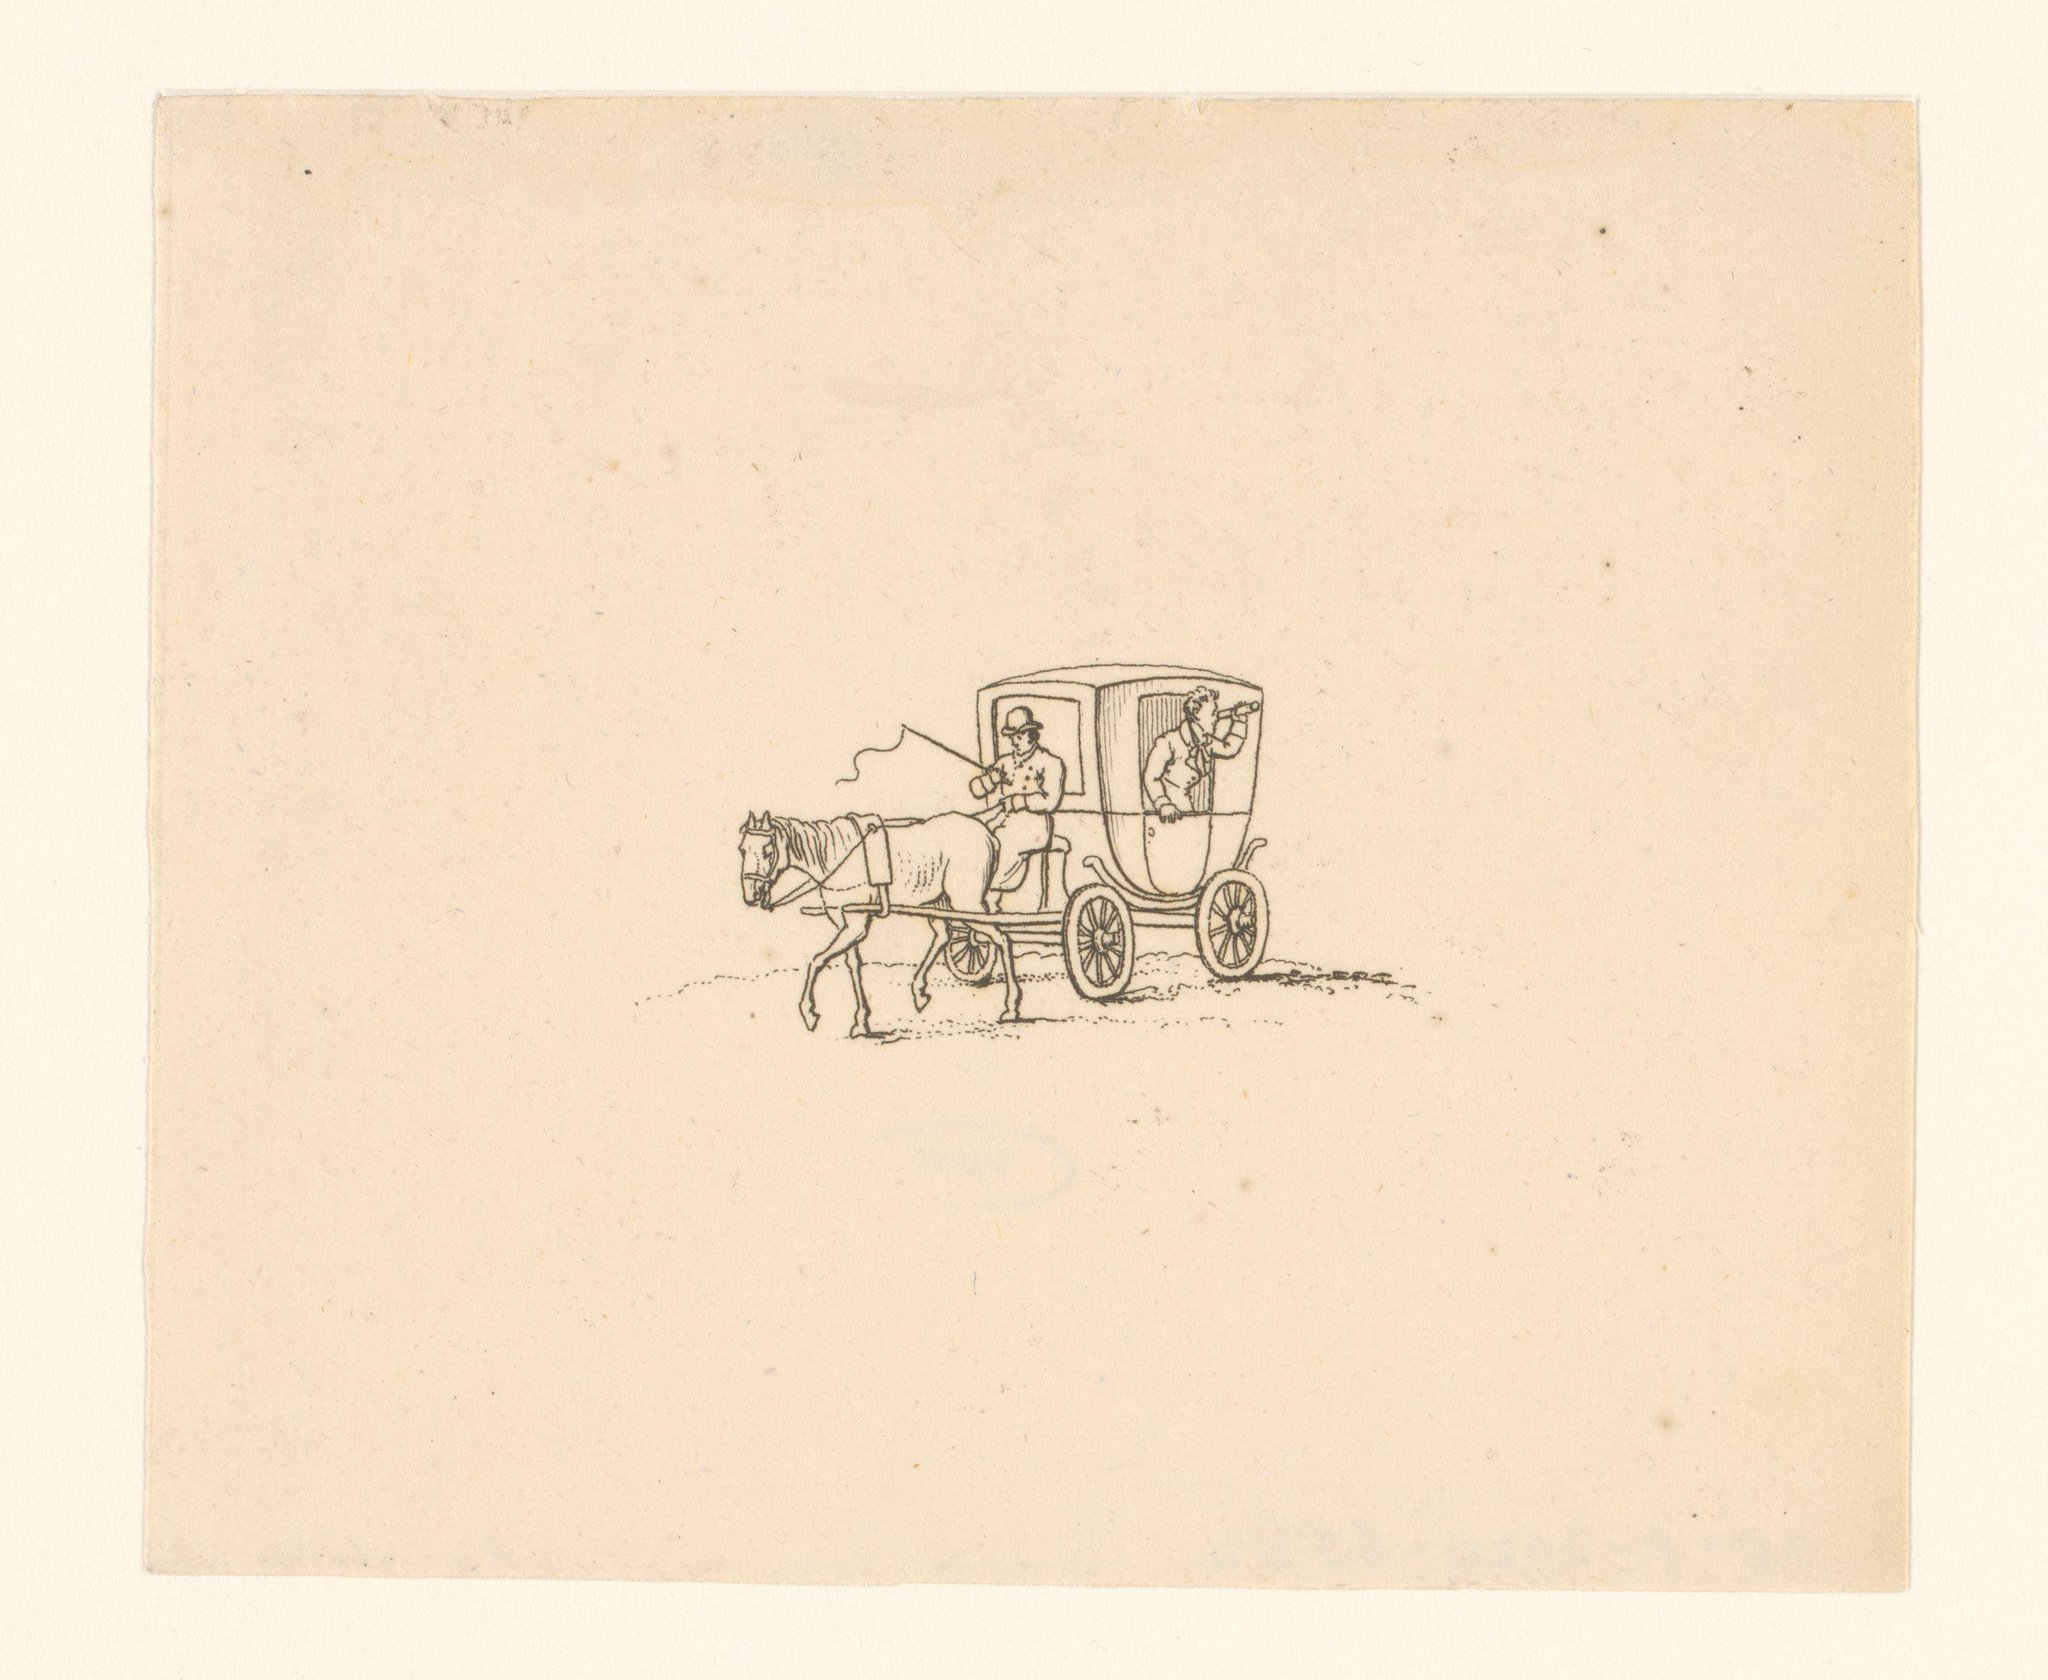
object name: print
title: Man kijkt met een verrekijker uit een koets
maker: Anonymous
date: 1800-1899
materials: paper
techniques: etching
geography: netherlands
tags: four-wheeled vehicle drawn by one animal, binoculars, spy-glass, etc.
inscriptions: collector's mark: Lugt 2228